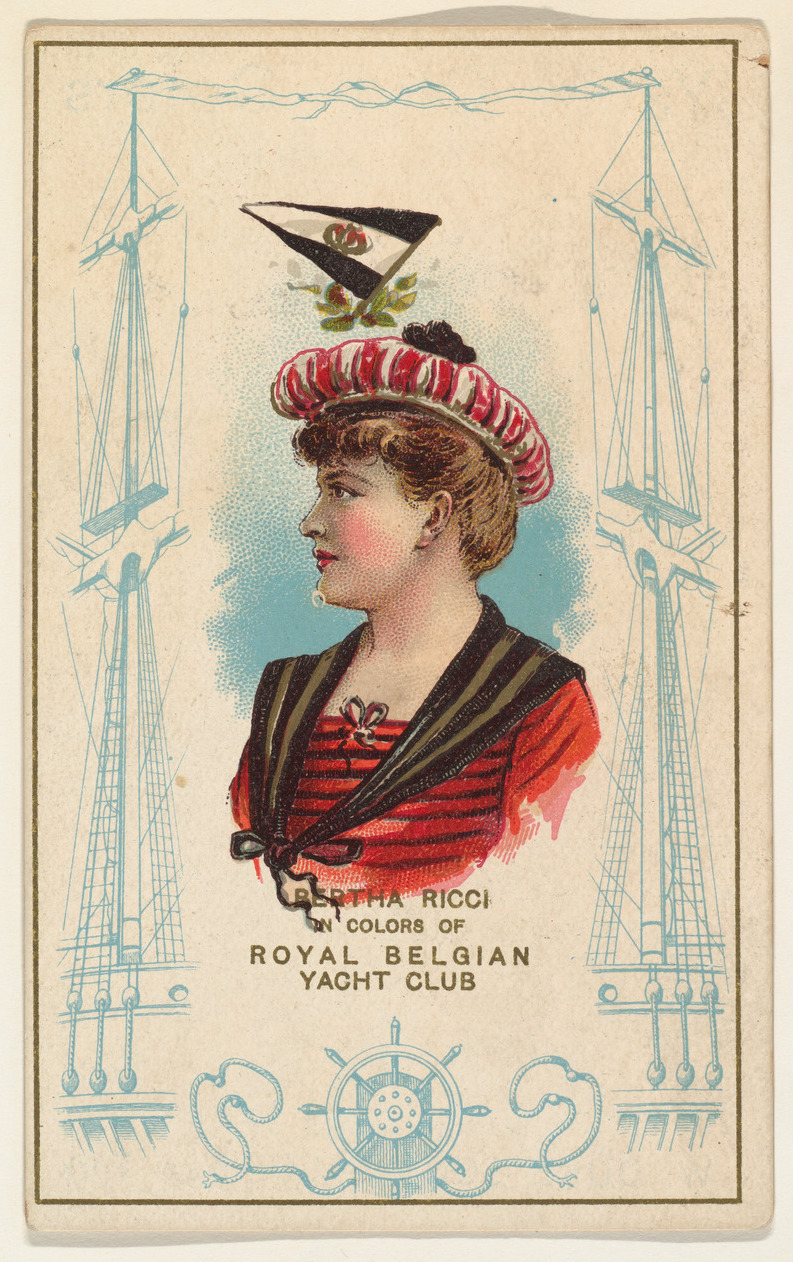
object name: print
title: Bertha Ricci in Colors of Royal Belgian Yacht Club, from the Yacht Colors of the World series (N140) issued by Duke Sons & Co. to promote Honest Long Cut Tobacco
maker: w. duke, sons & co.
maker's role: publisher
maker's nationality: american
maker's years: 1870-1920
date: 1890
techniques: color lithograph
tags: profiles,women,flags